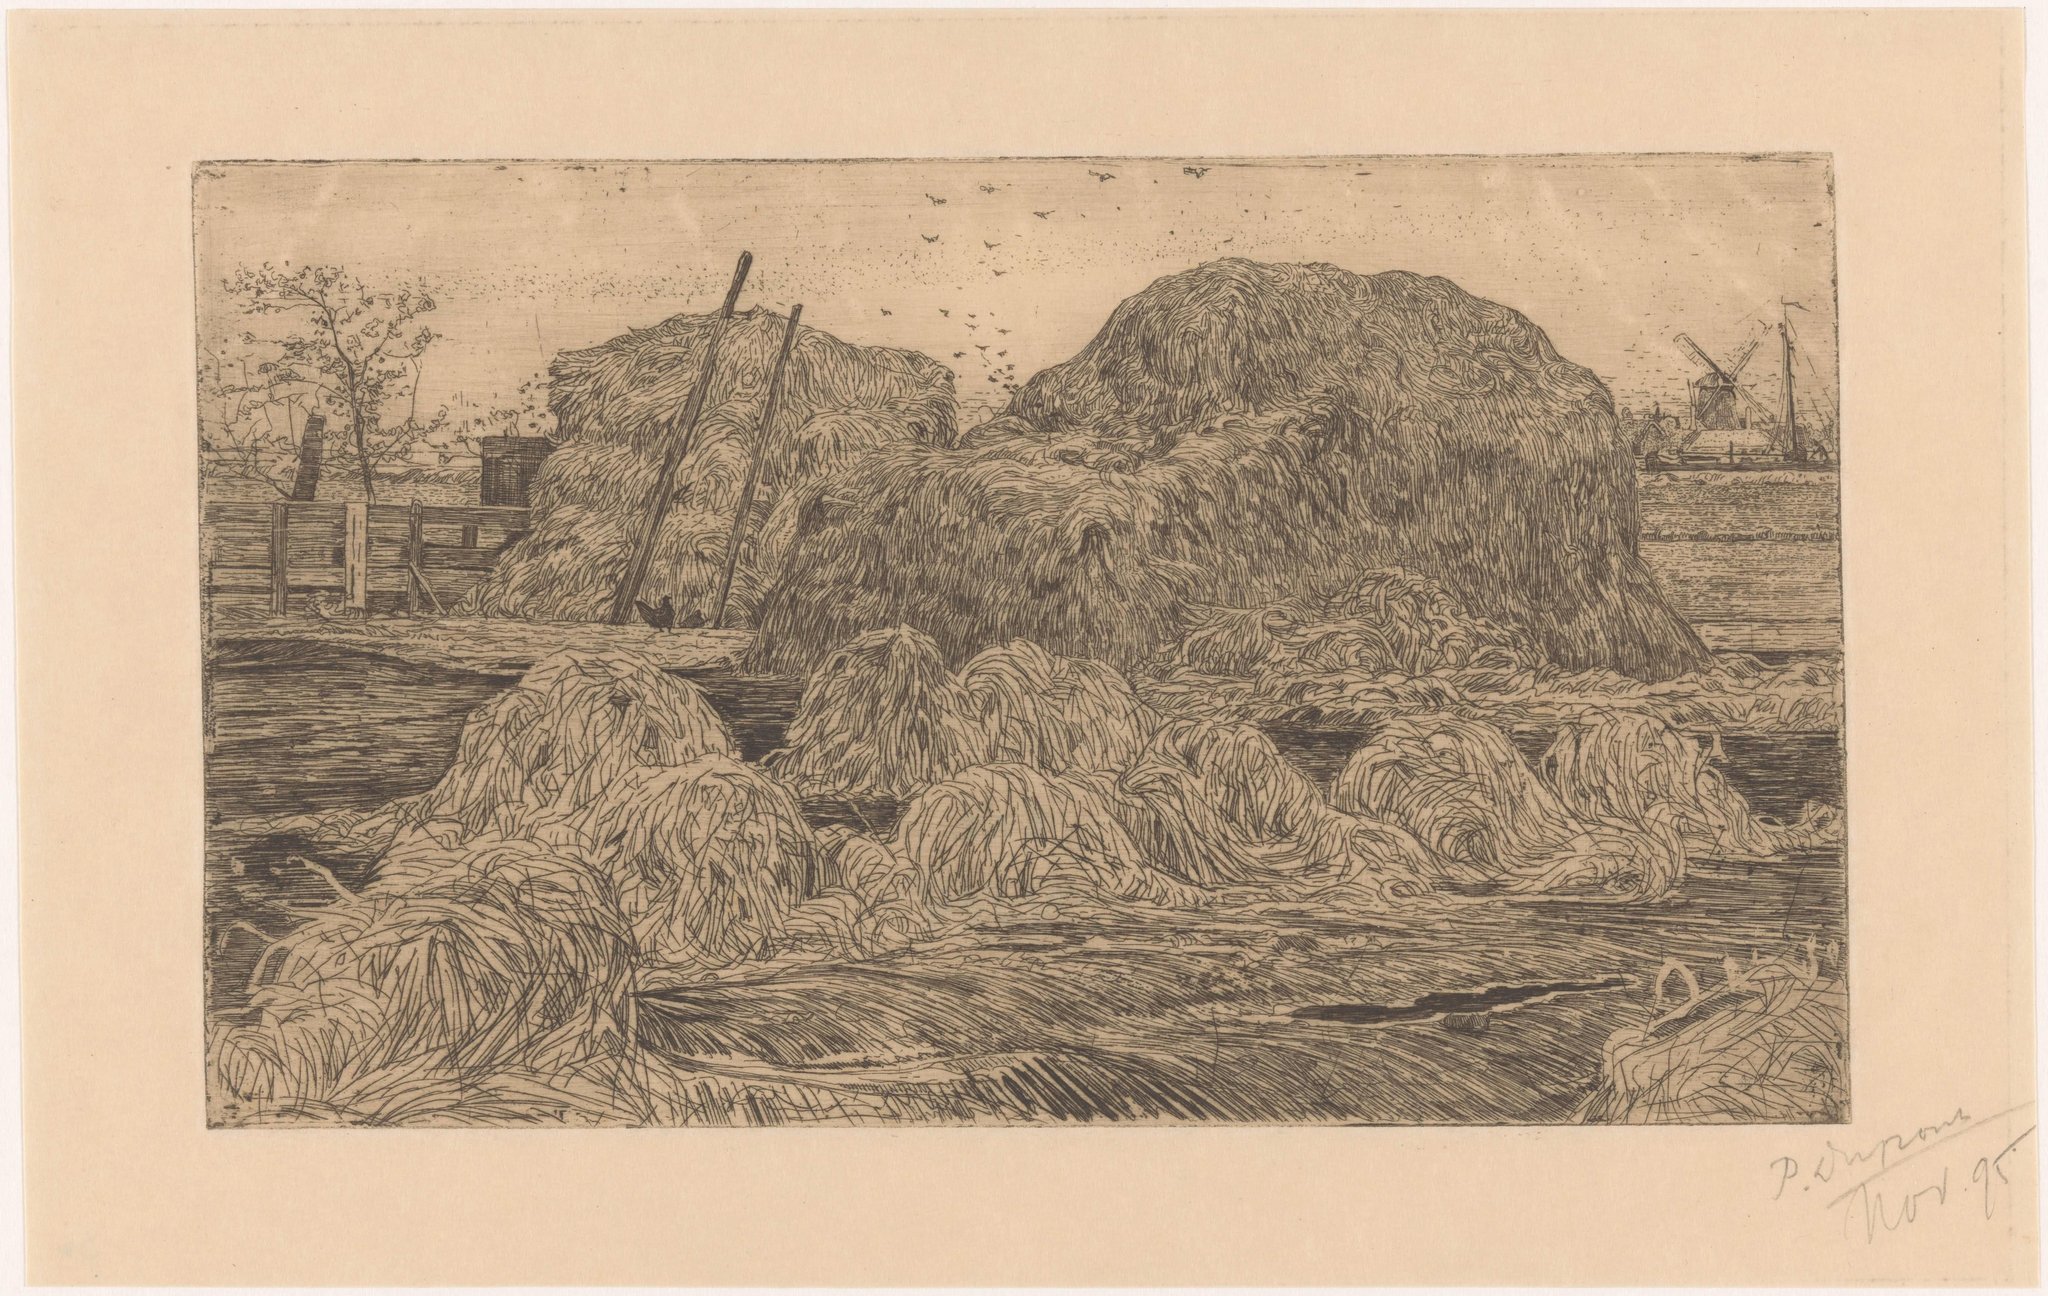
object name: print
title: Hooibergen op een akker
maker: pieter dupont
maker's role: draughtsman, print maker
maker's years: 1870-1911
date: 1811-1895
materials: paper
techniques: intaglio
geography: north holland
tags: hay-stack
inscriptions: collector's mark: Lugt 2233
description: Rechts op de achtergrond een molen en een zeilschip.